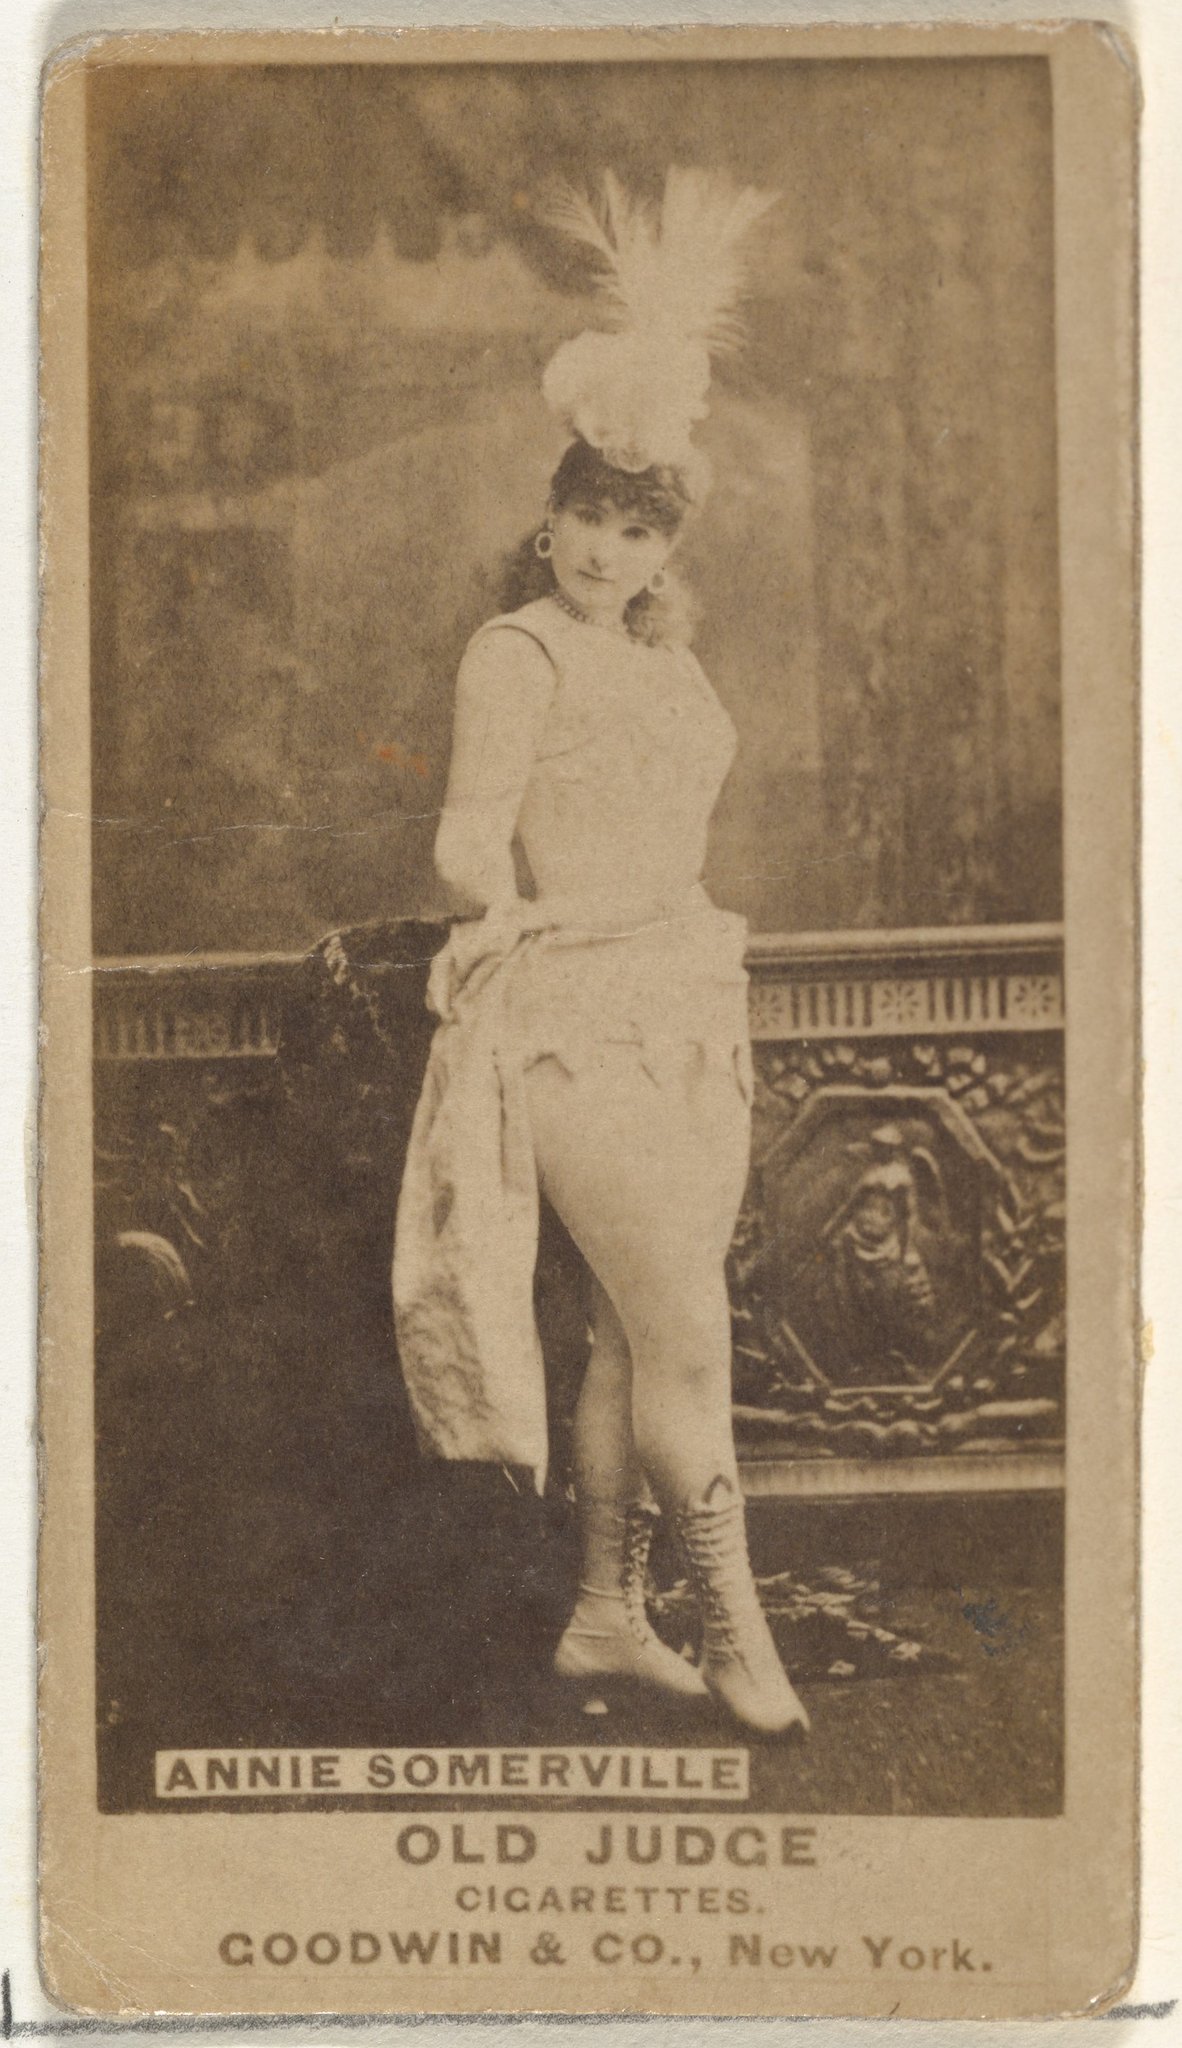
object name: photograph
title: Annie Somerville, from the Actors and Actresses series (N171) for Old Judge Cigarettes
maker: goodwin & company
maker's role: publisher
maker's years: 1850-1950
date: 1886-1890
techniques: albumen silver print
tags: portraits,women,actresses